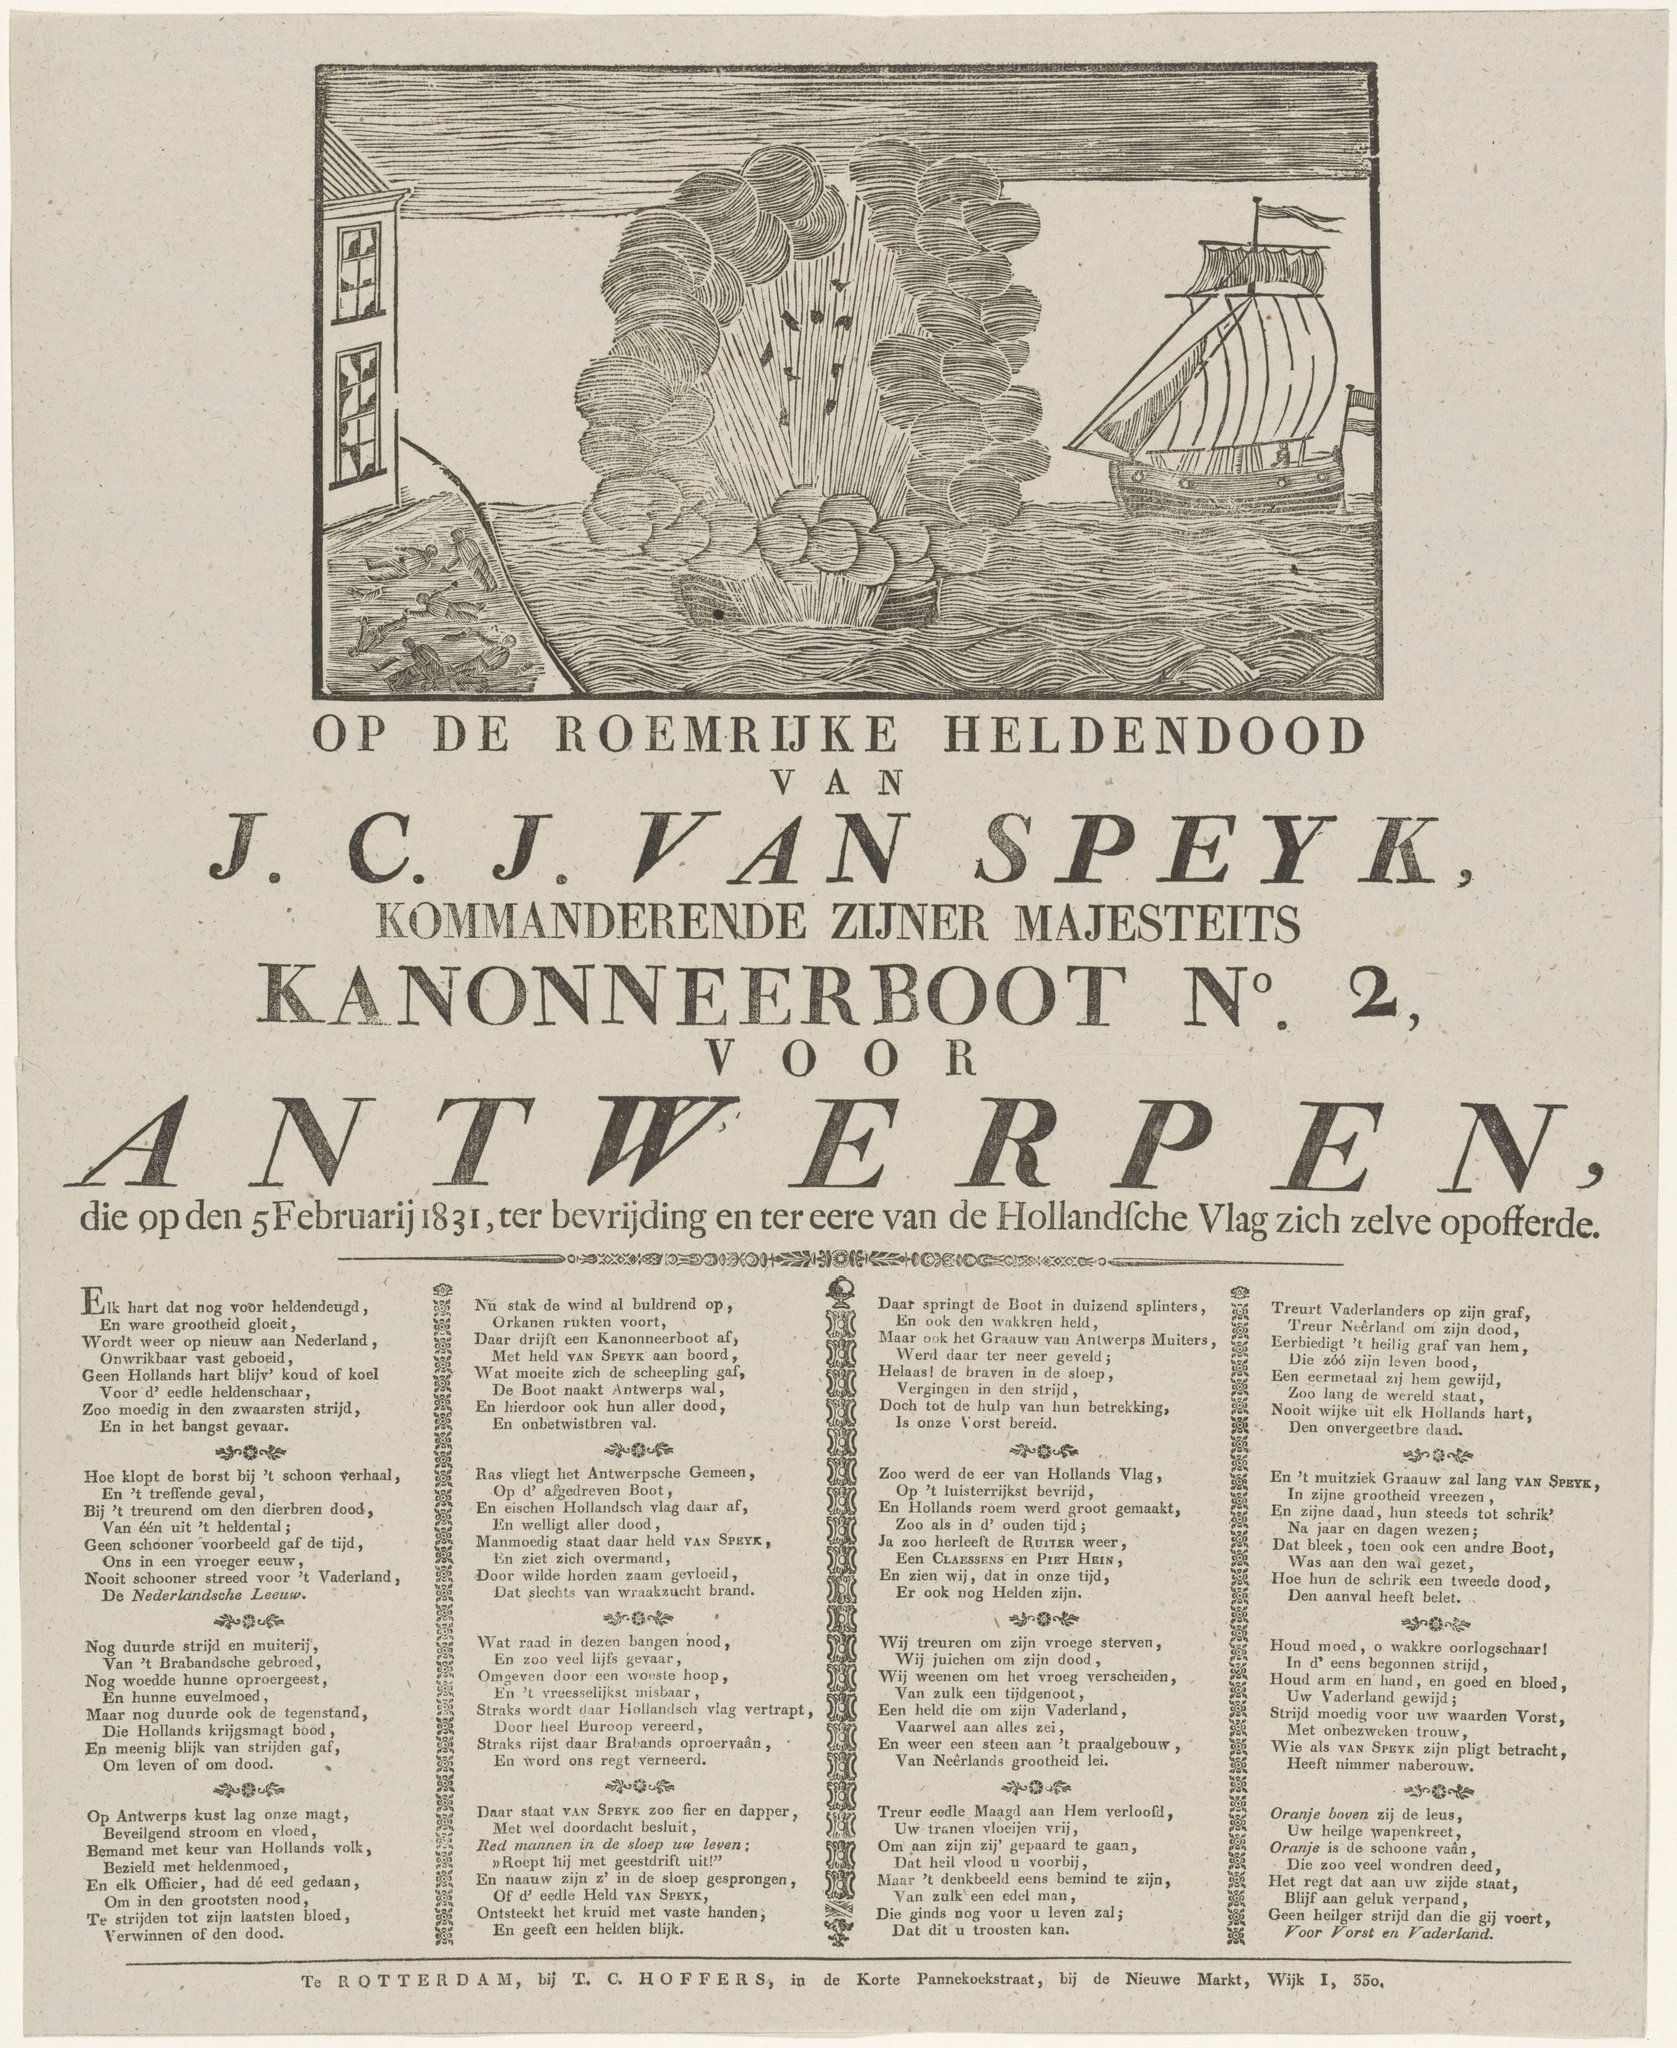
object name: print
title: Op de roemrijke heldendood van J.C.J. van Speyk, kommanderende zijner majesteits Kanonneerboot No. 2, voor Antwerpen, die op den 5 Februarij 1831, ter bevrijding en ter eere van de Hollandsche Vlag zich zelve opofferde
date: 1831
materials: paper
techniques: letterpress printing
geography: netherlands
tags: amsterdam, antwerp, jan van speyk, navy (+ sailing-ships), self-sacrifice, death in the service of a higher purpose, gunpowder disaster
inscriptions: collector's mark: Lugt 2228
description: Het in de lucht springen van de kanonneerboot van Jan van Speyk op de Schelde voor Antwerpen, 5 februari 1831. Op de voorgrond lichamen van slachtoffers op de kade. Met een vers in zestien coupletten.